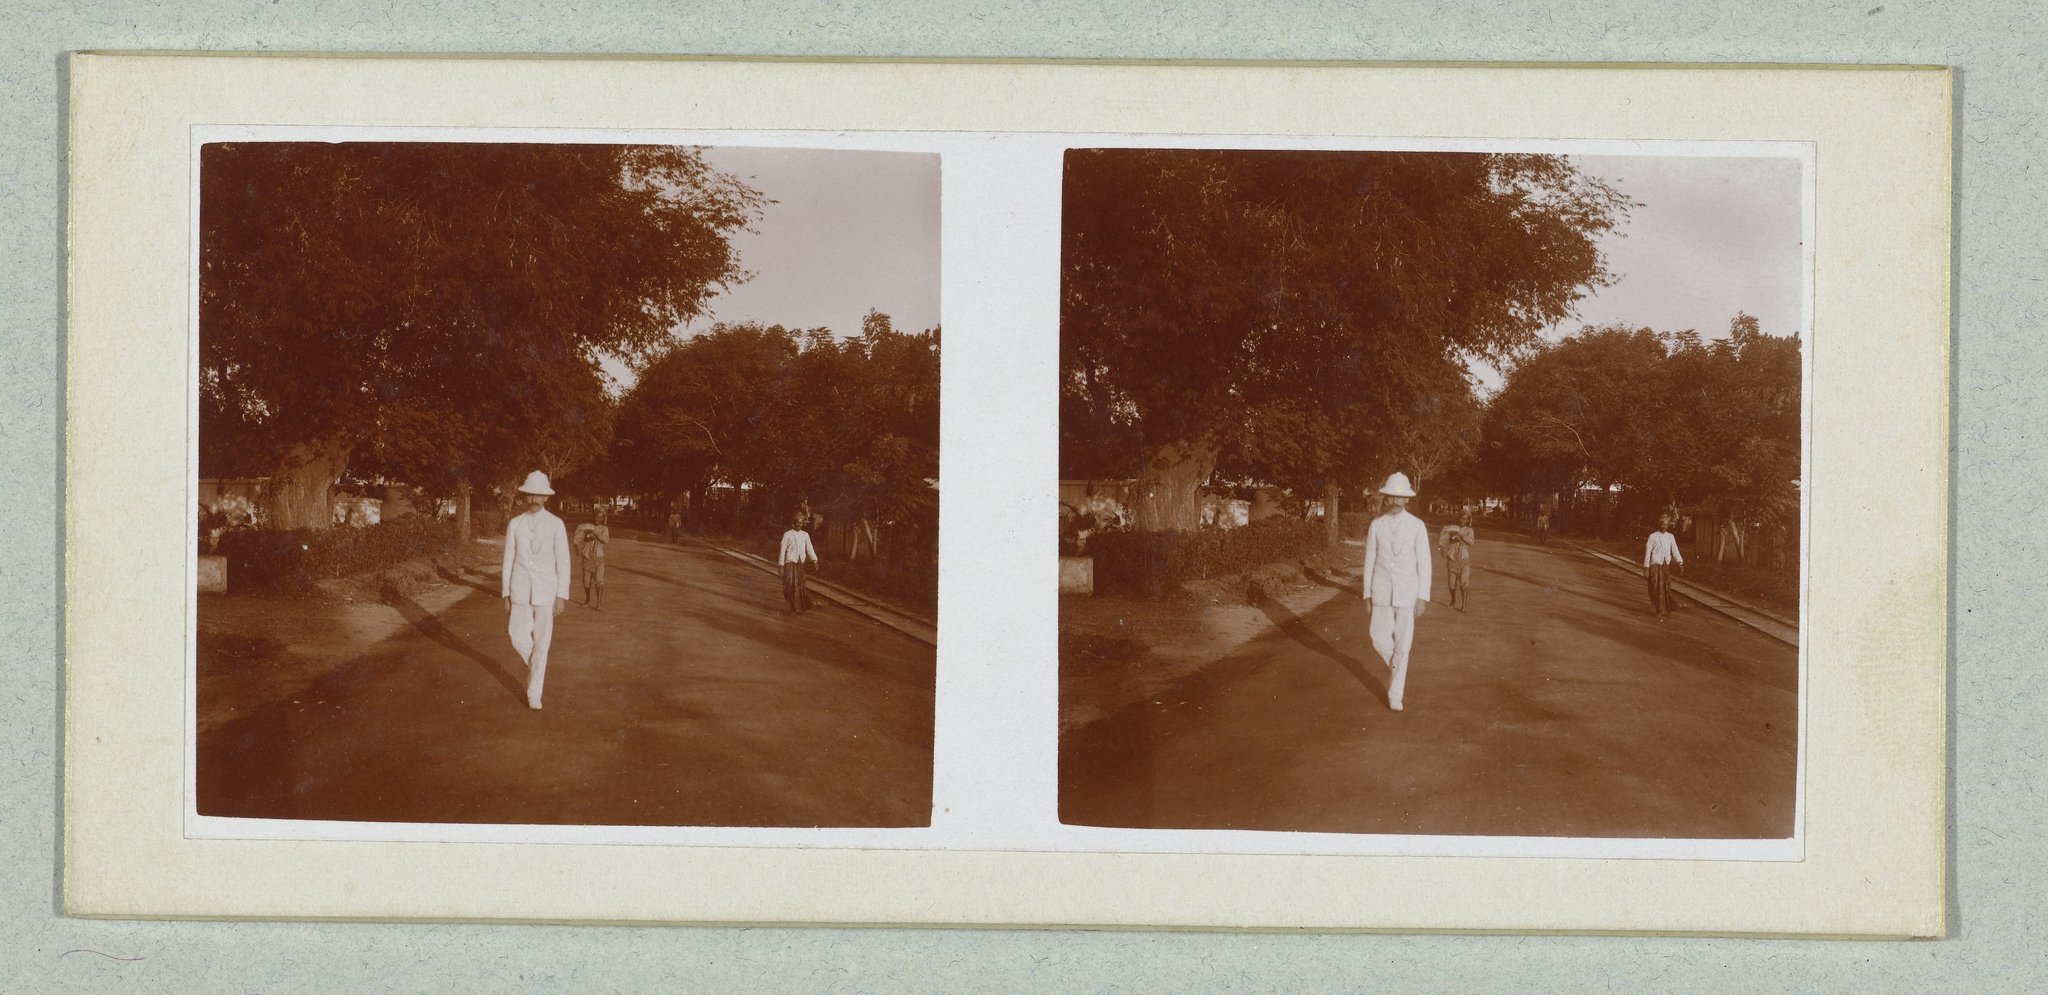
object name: stereograph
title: Photographieën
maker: frits freerks fontein fz.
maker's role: fotograaf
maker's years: 1882-1928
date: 1910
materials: cardboard, paper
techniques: gelatin silver print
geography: madura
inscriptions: caption: ‘Batoewan bij Soemenep 1910’